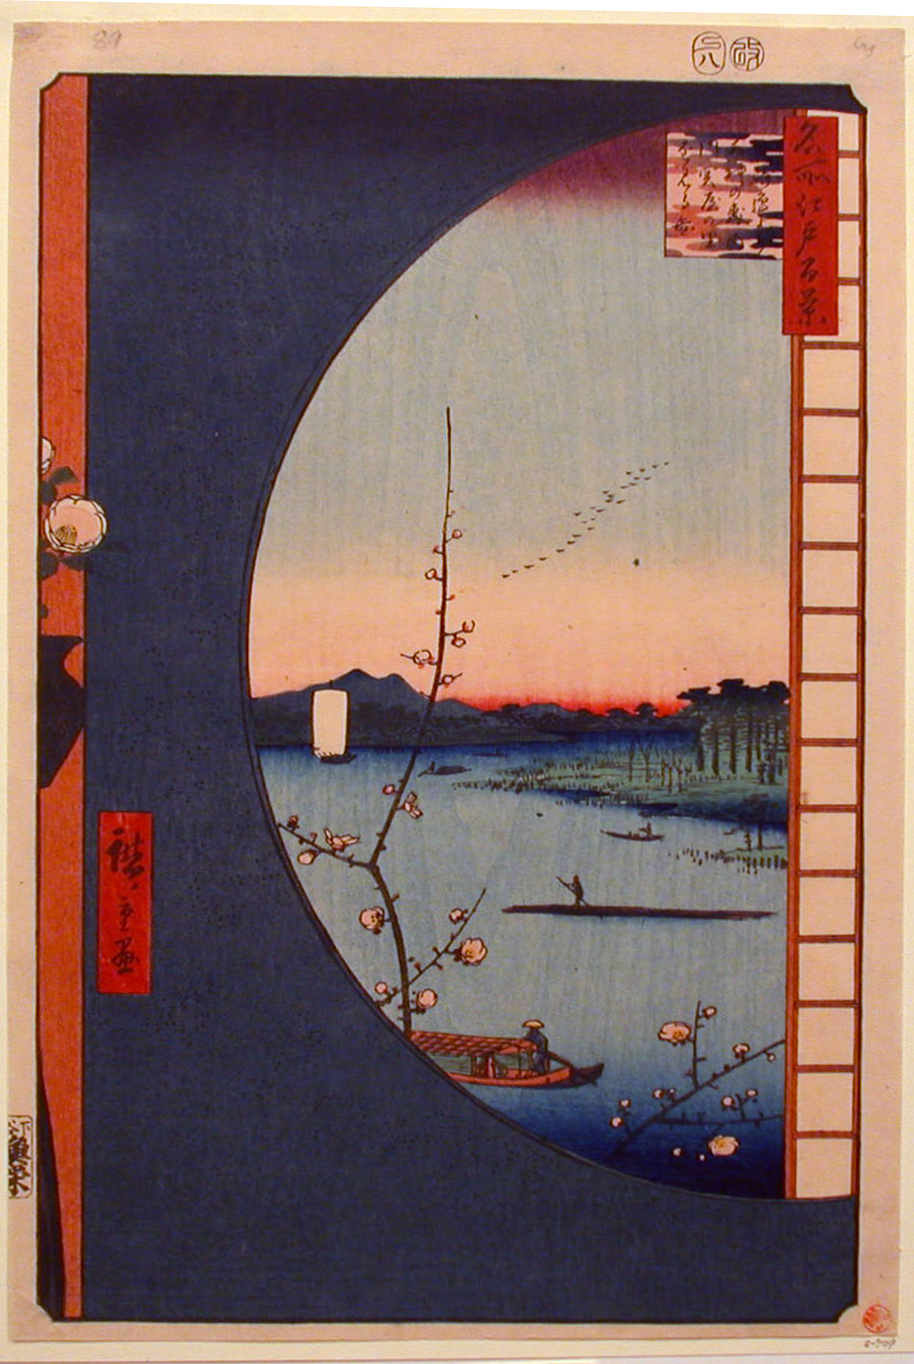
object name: print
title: Small View of Yedo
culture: japanese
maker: utagawa hiroshige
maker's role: artist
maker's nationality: japanese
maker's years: 1797-1858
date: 1817-1858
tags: landscapes,boats